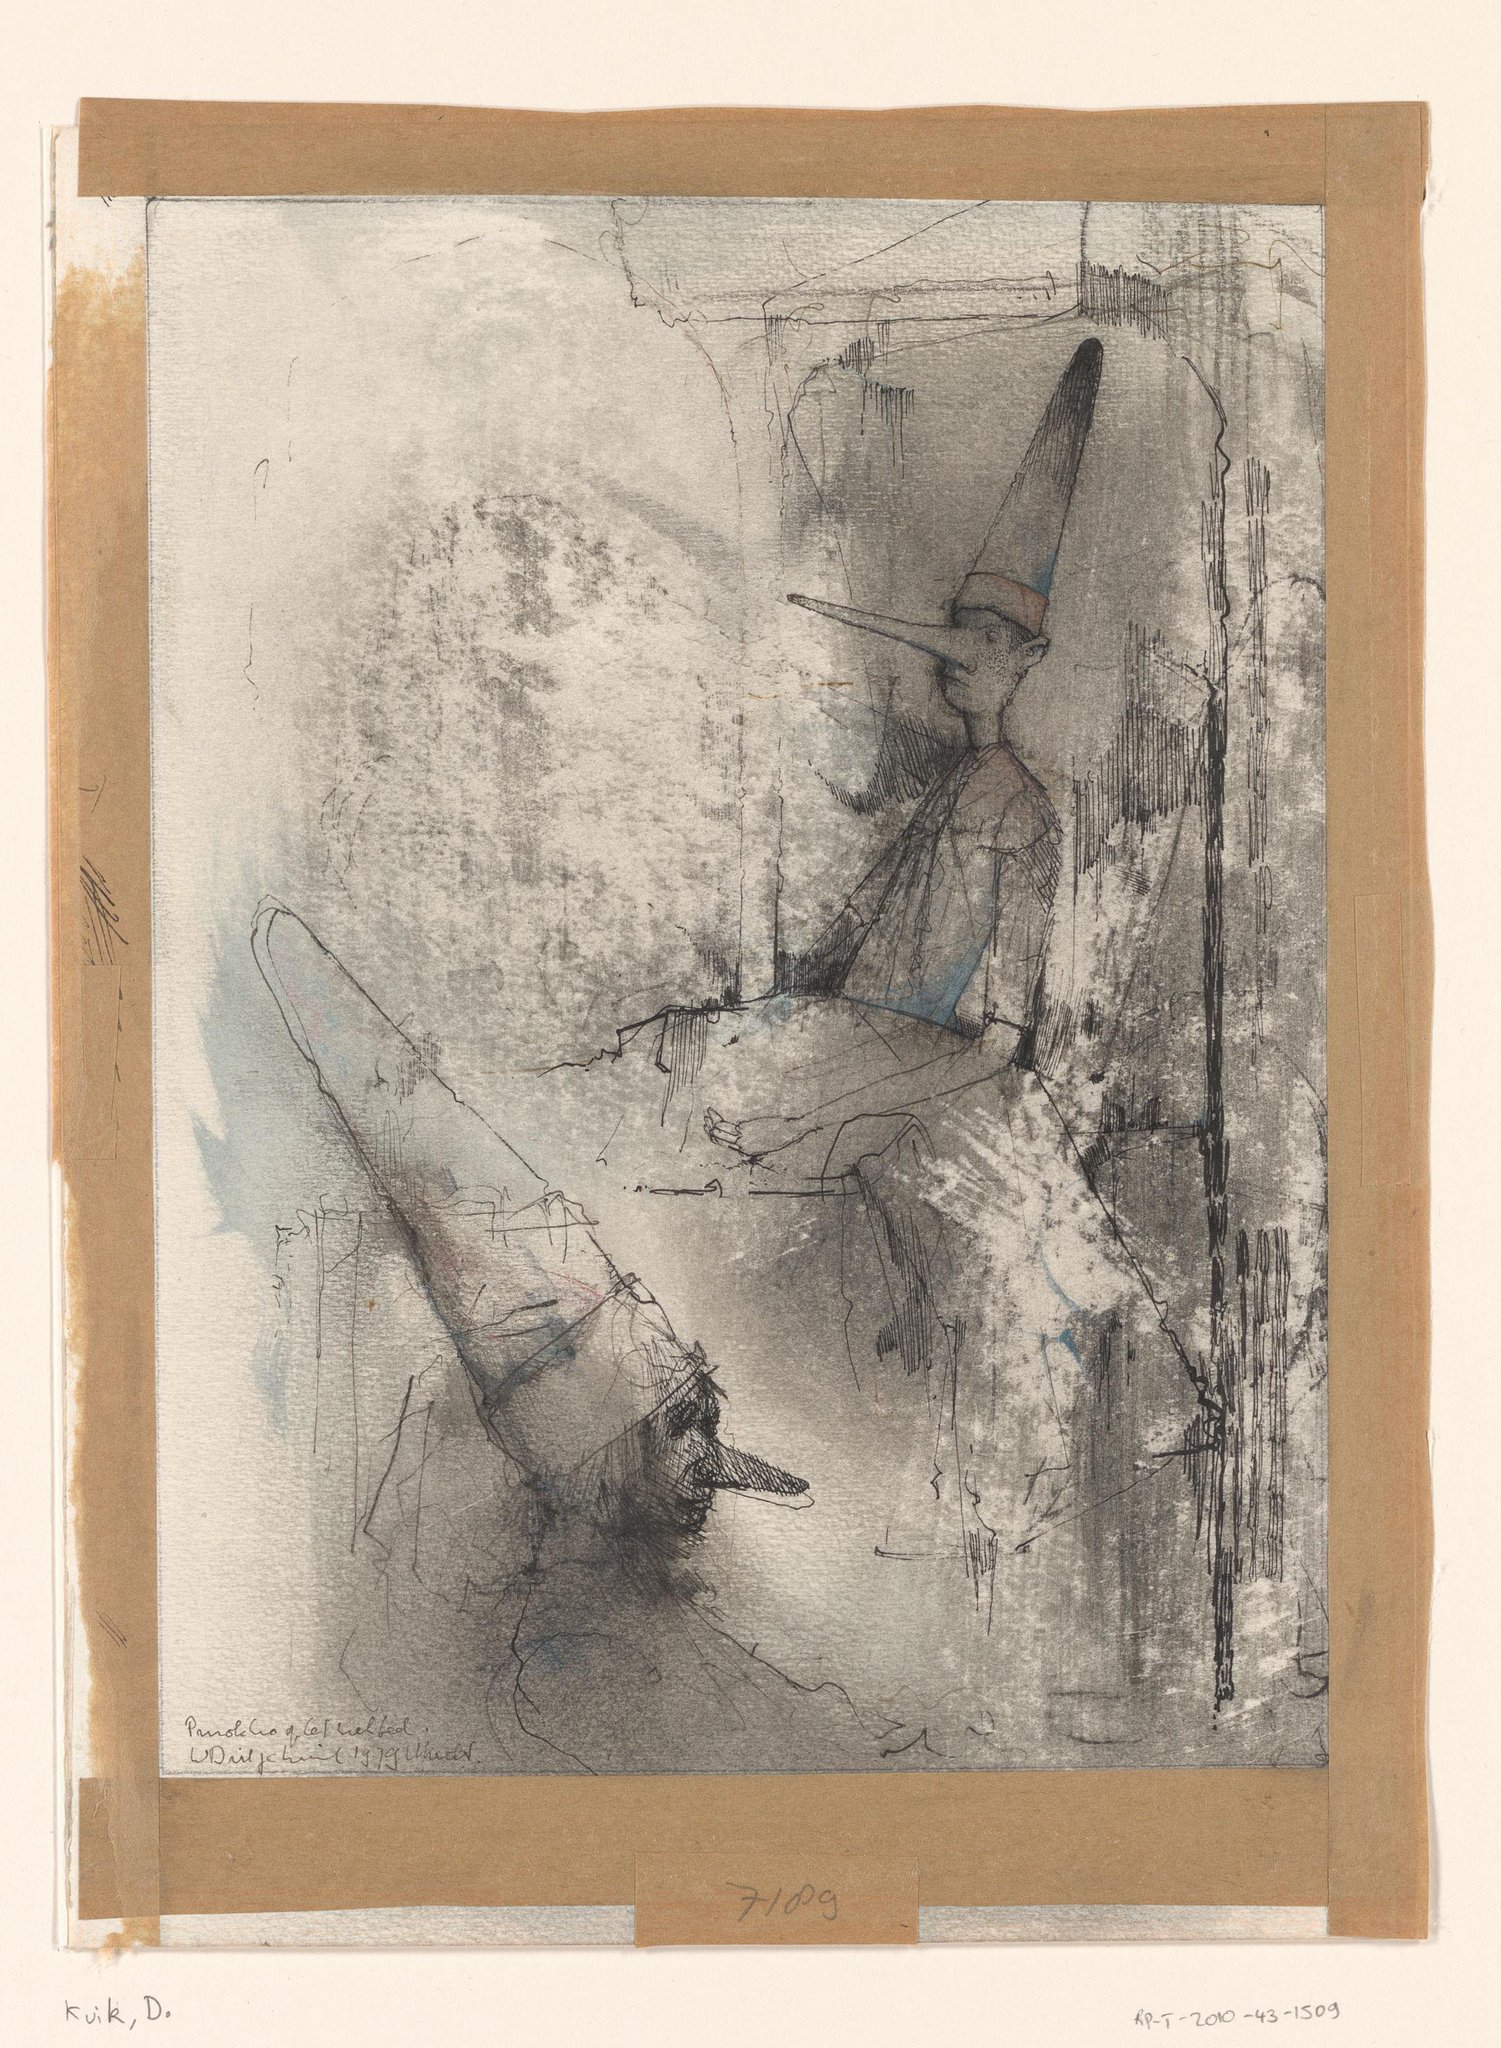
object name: drawing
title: Pinokkio op het ziekbed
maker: dirkje kuik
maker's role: print maker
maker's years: 1929-2008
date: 1979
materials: ink, paper, watercolor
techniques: brush, pen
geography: utrecht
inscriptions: signature, date and inscription: ‘Pinokkio op het ziekbed/ WDirkje Kuik 1979 Utrecht’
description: Jongen met lange neus en een puntmuts, rechtop zittend in bed, linksonder een andere figuur met lange neus en puntmuts, en profil.